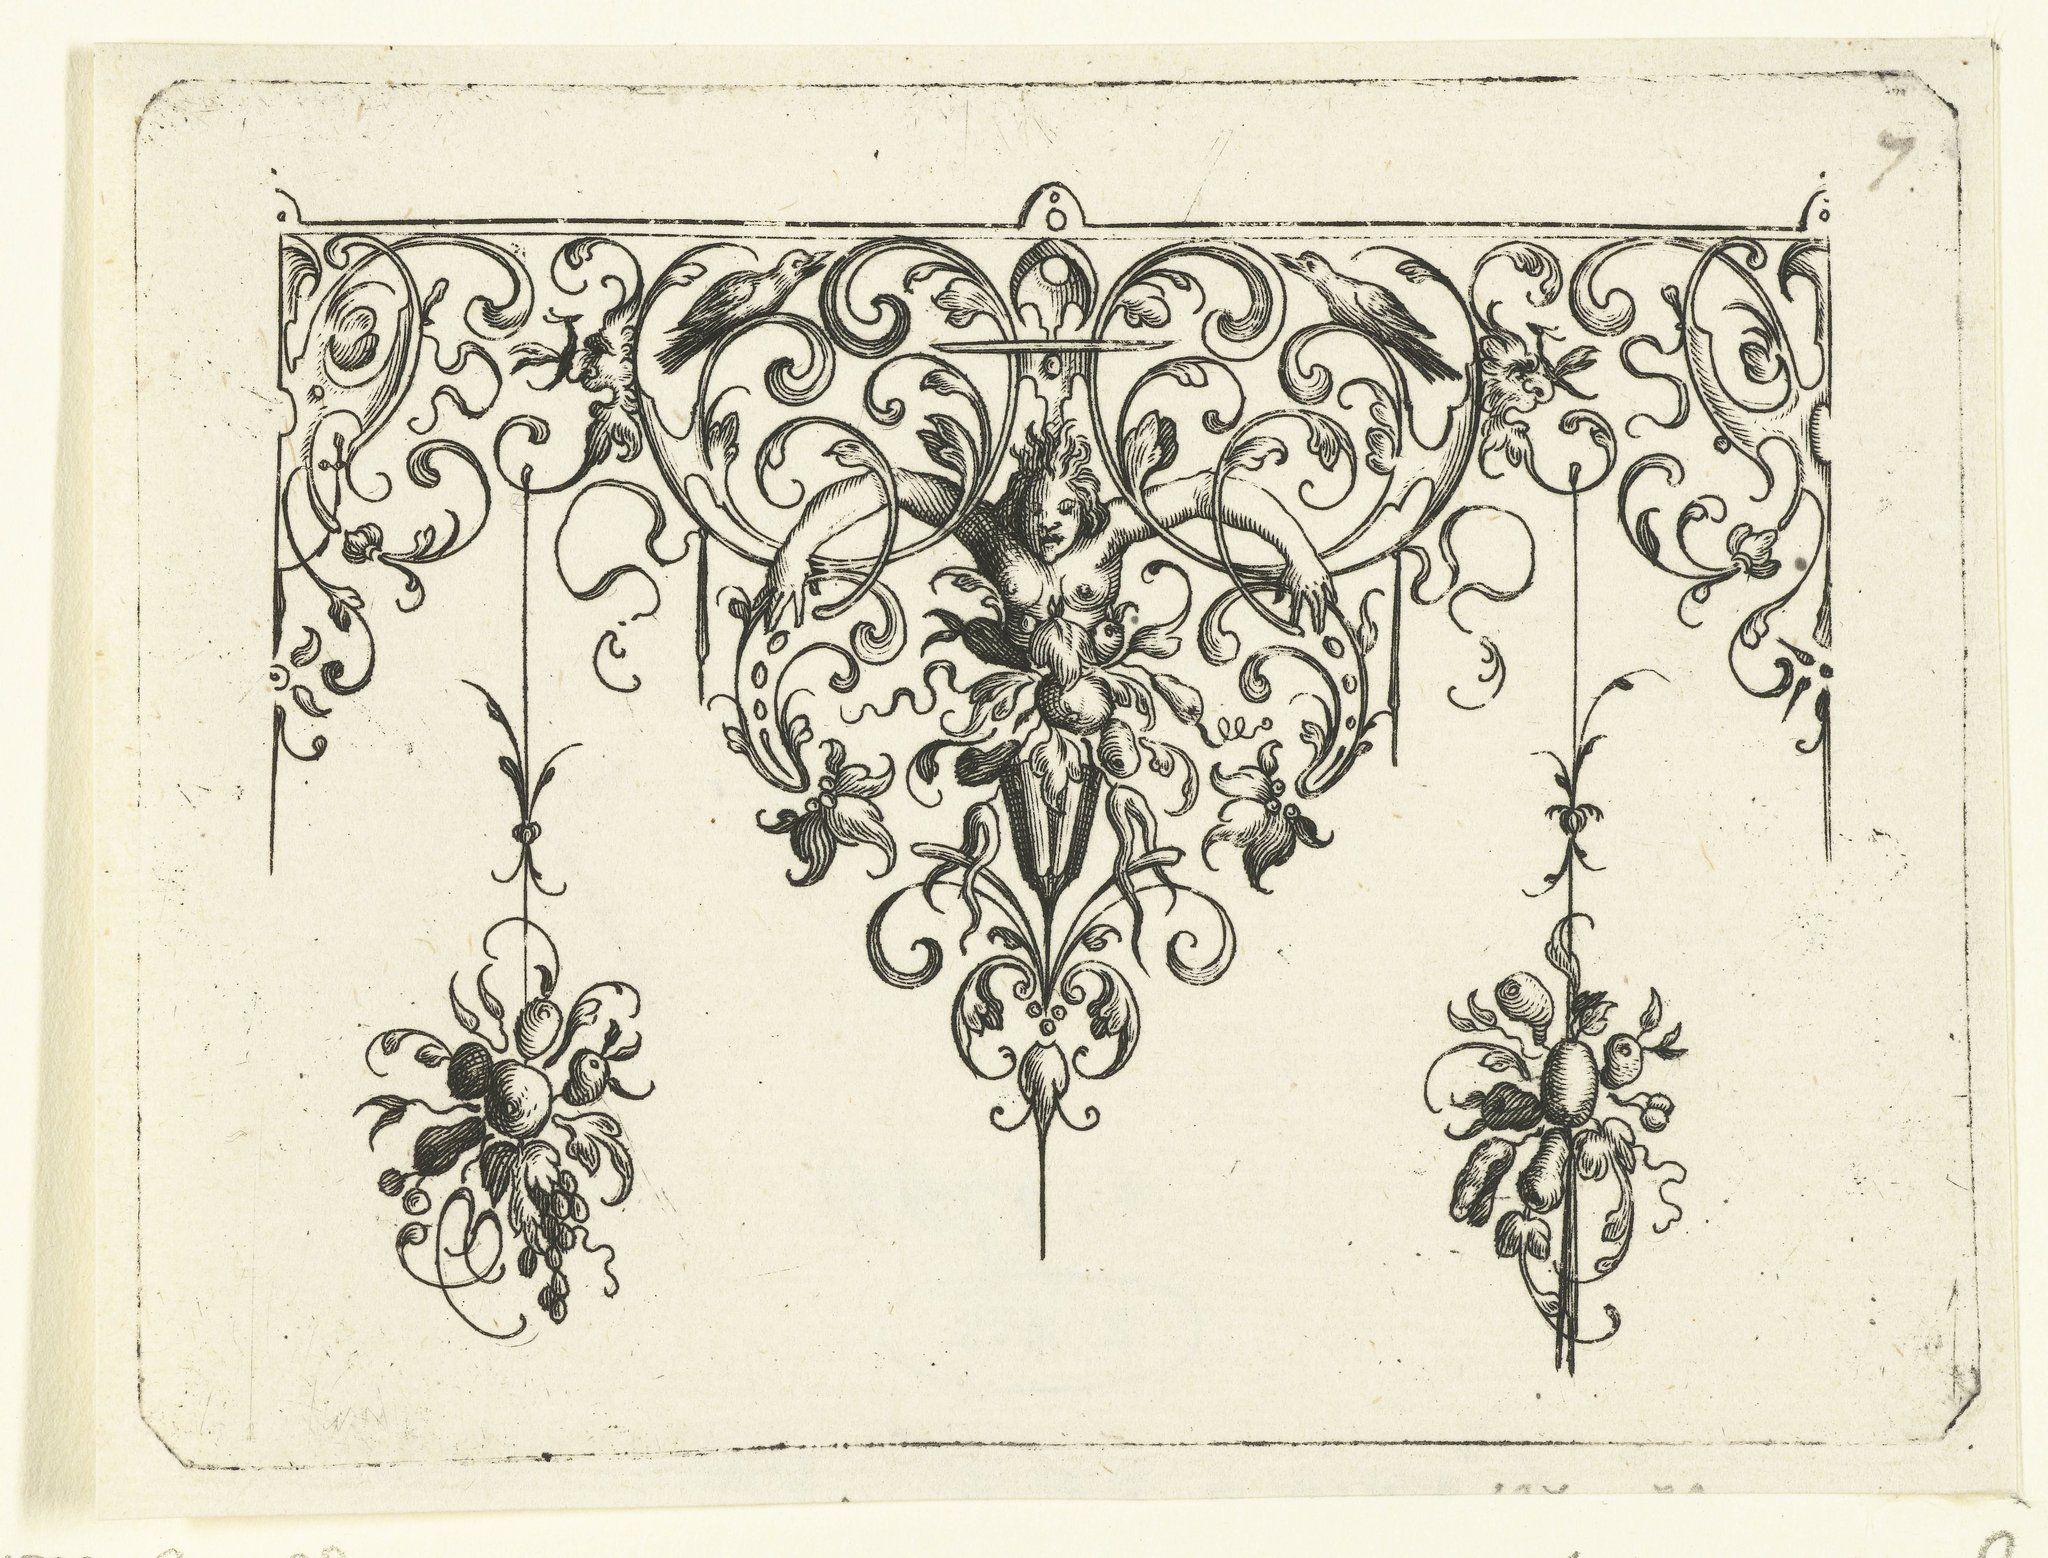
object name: ornament print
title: Spits met vrouwelijk torso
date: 1611-1635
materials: paper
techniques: engraving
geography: nuremberg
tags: fantasy ornament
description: Kopie van serie met dezelfde titel, uitgegeven door Michiel le Blon. Blad 7 uit serie van 14 bladen met voorbeelden voor gegraveerde decoratieranden van bekers in de vorm van driehoeken bestaande uit ranken, Schweifwerk, guirlandes met putti, dieren, vogels en maskers.